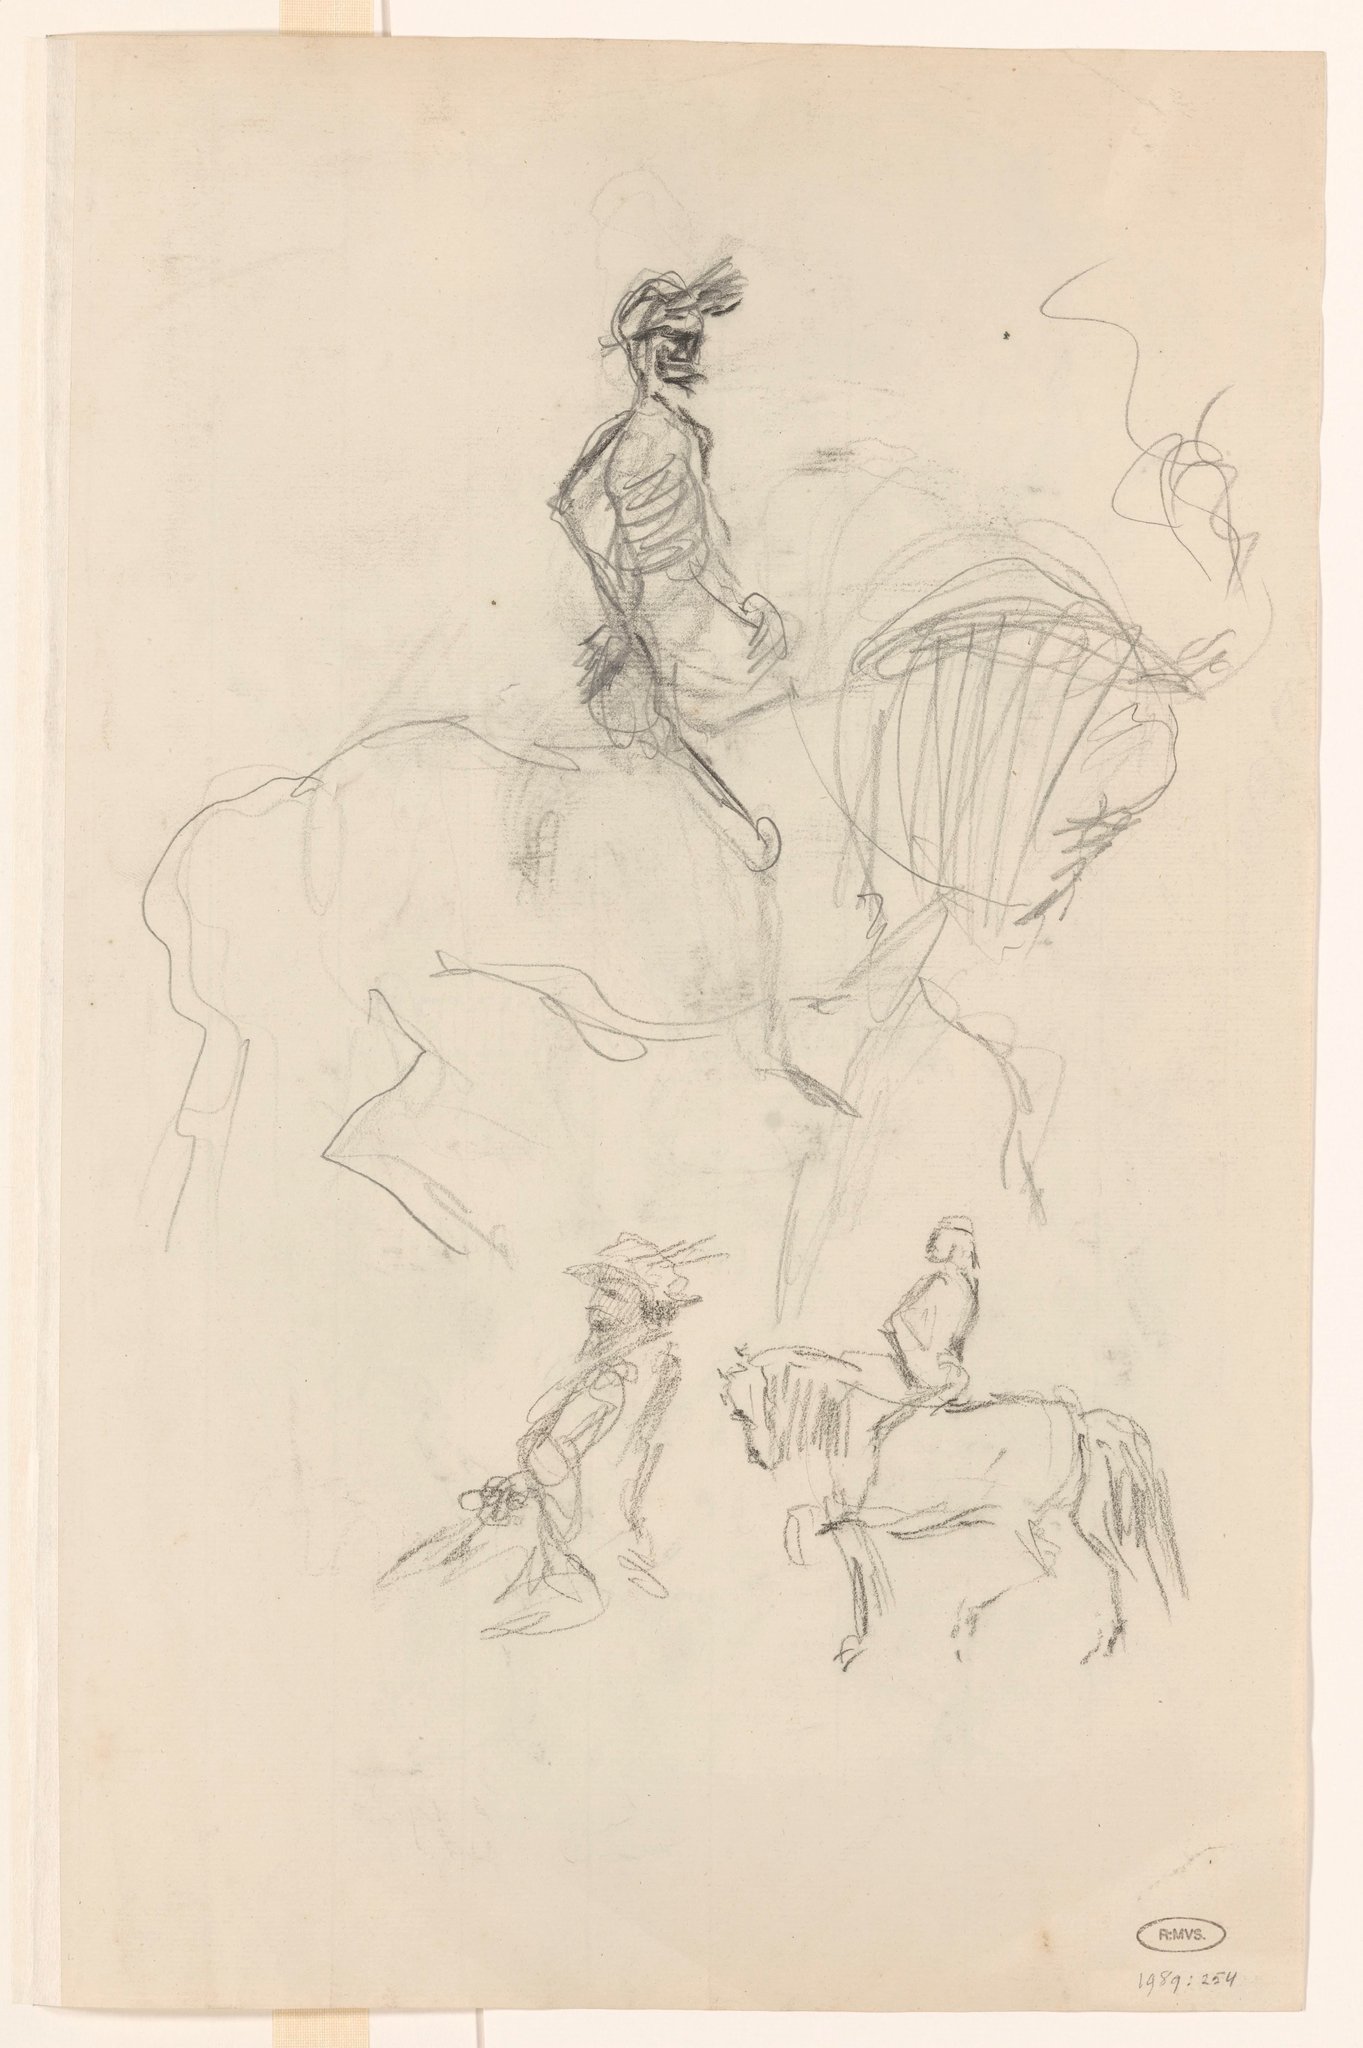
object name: drawing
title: Studies van de Dood te paard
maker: carel vosmaer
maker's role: draughtsman, print maker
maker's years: 1826-1888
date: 1836-1888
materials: chalk, paper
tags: riding a horse, ass, or mule; rider, horseman, death as skeleton